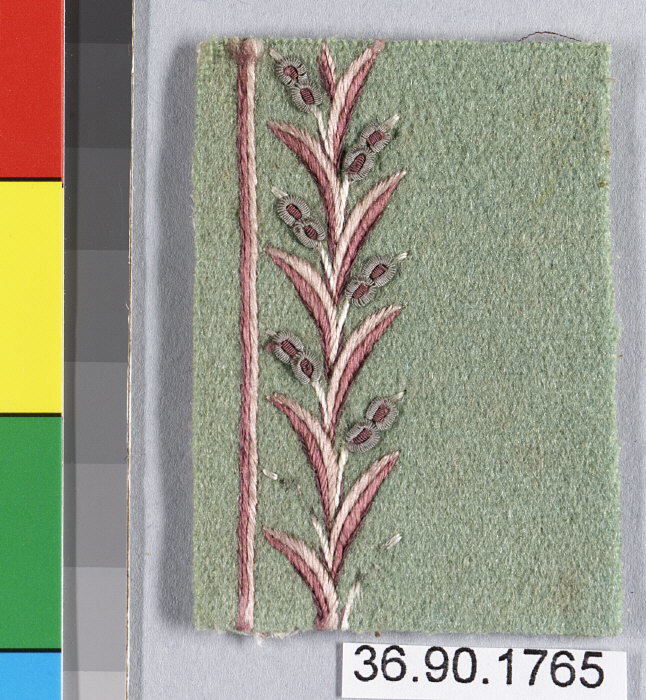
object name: sample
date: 1801-1833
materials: felt, metal thread, silk